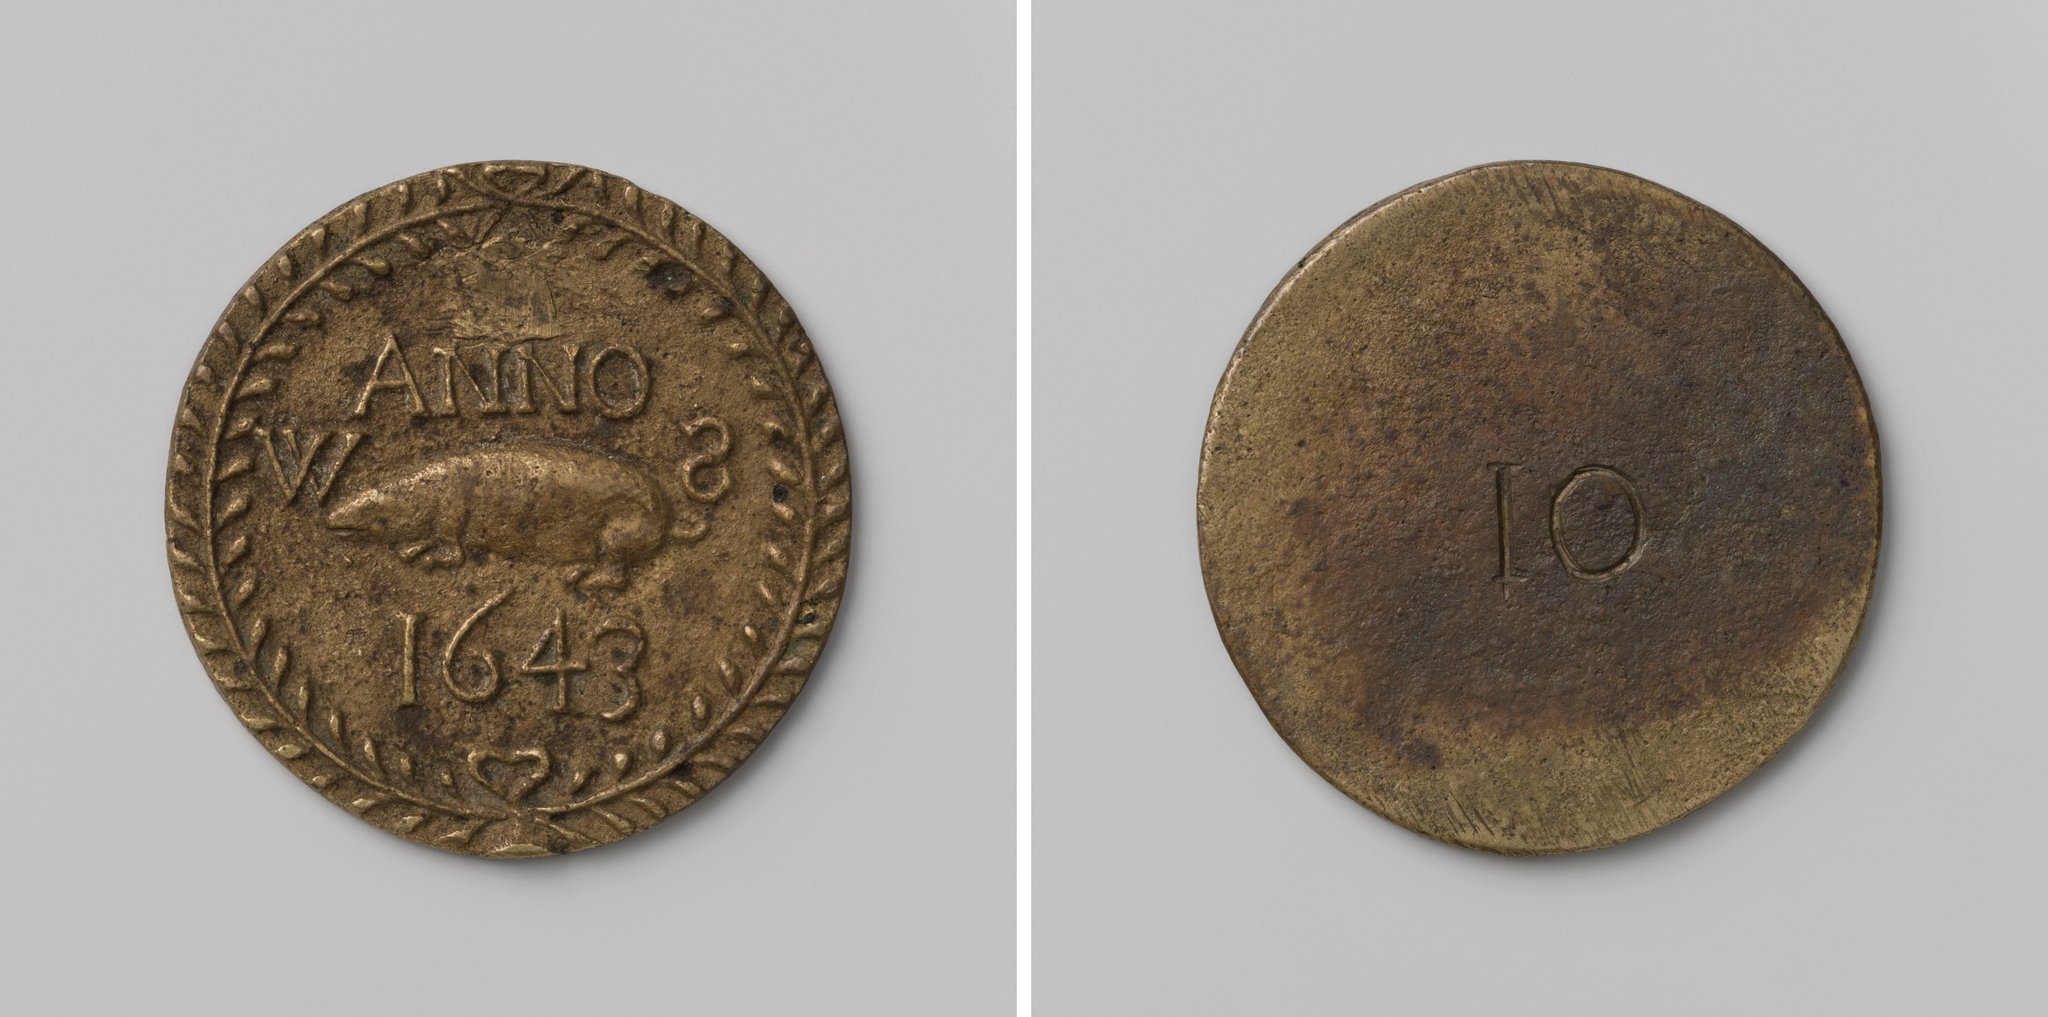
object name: medal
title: Varkensslagersgilde, gildepenning met no. 10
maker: Anonymous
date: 1643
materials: brass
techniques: casting, engraving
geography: netherlands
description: Messing penning. Voorzijde: liggend varken onder opschrift tussen letters W en -in spiegelschrift- S boven jaartal binnen bladerkrans. Keerzijde: cijfer 10.